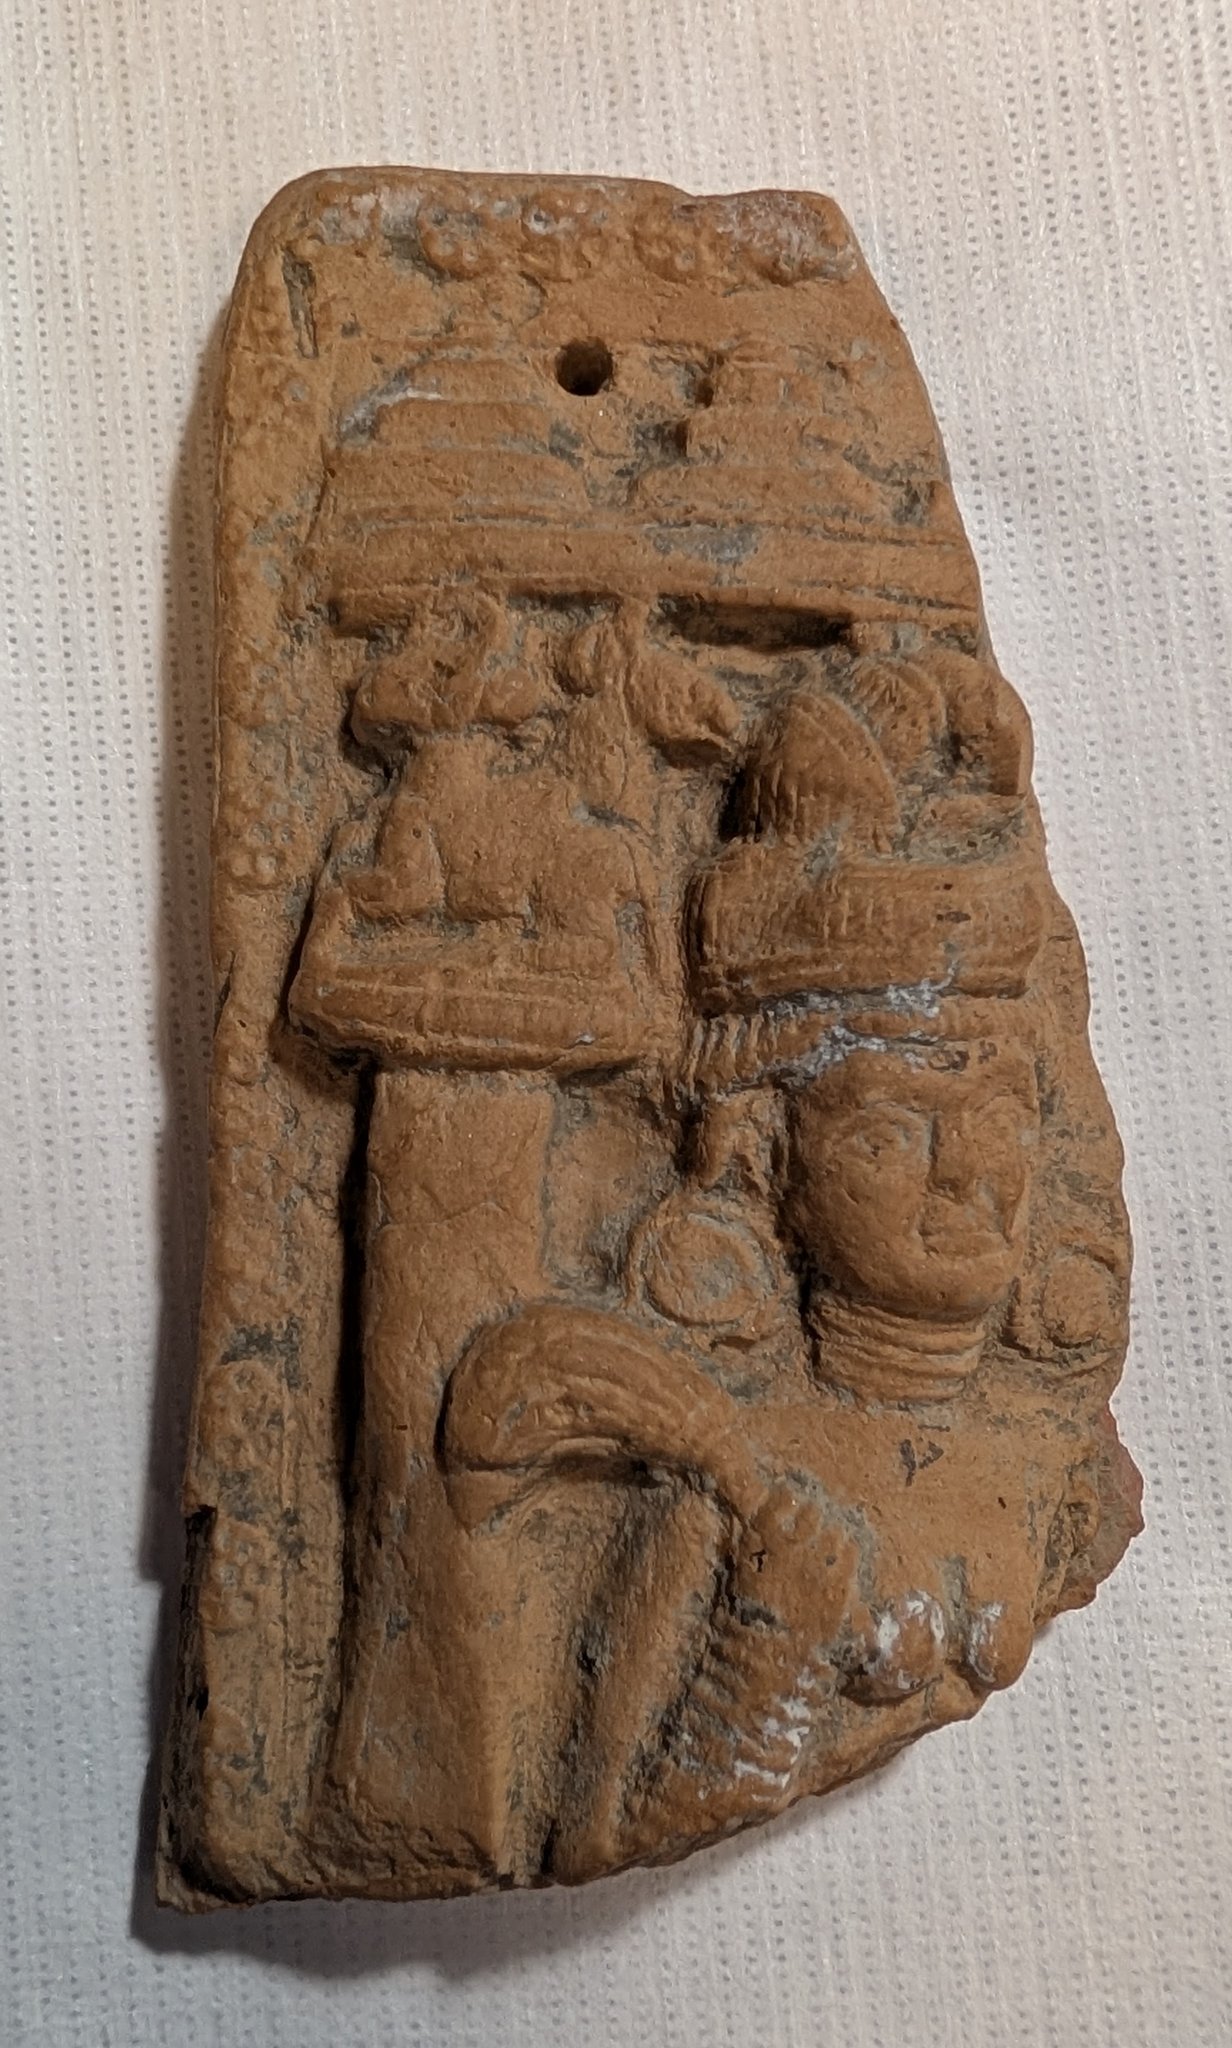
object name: plaque fragment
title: Fragment of a Plaque with a Female Head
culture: indian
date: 100-1 BCE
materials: terracotta